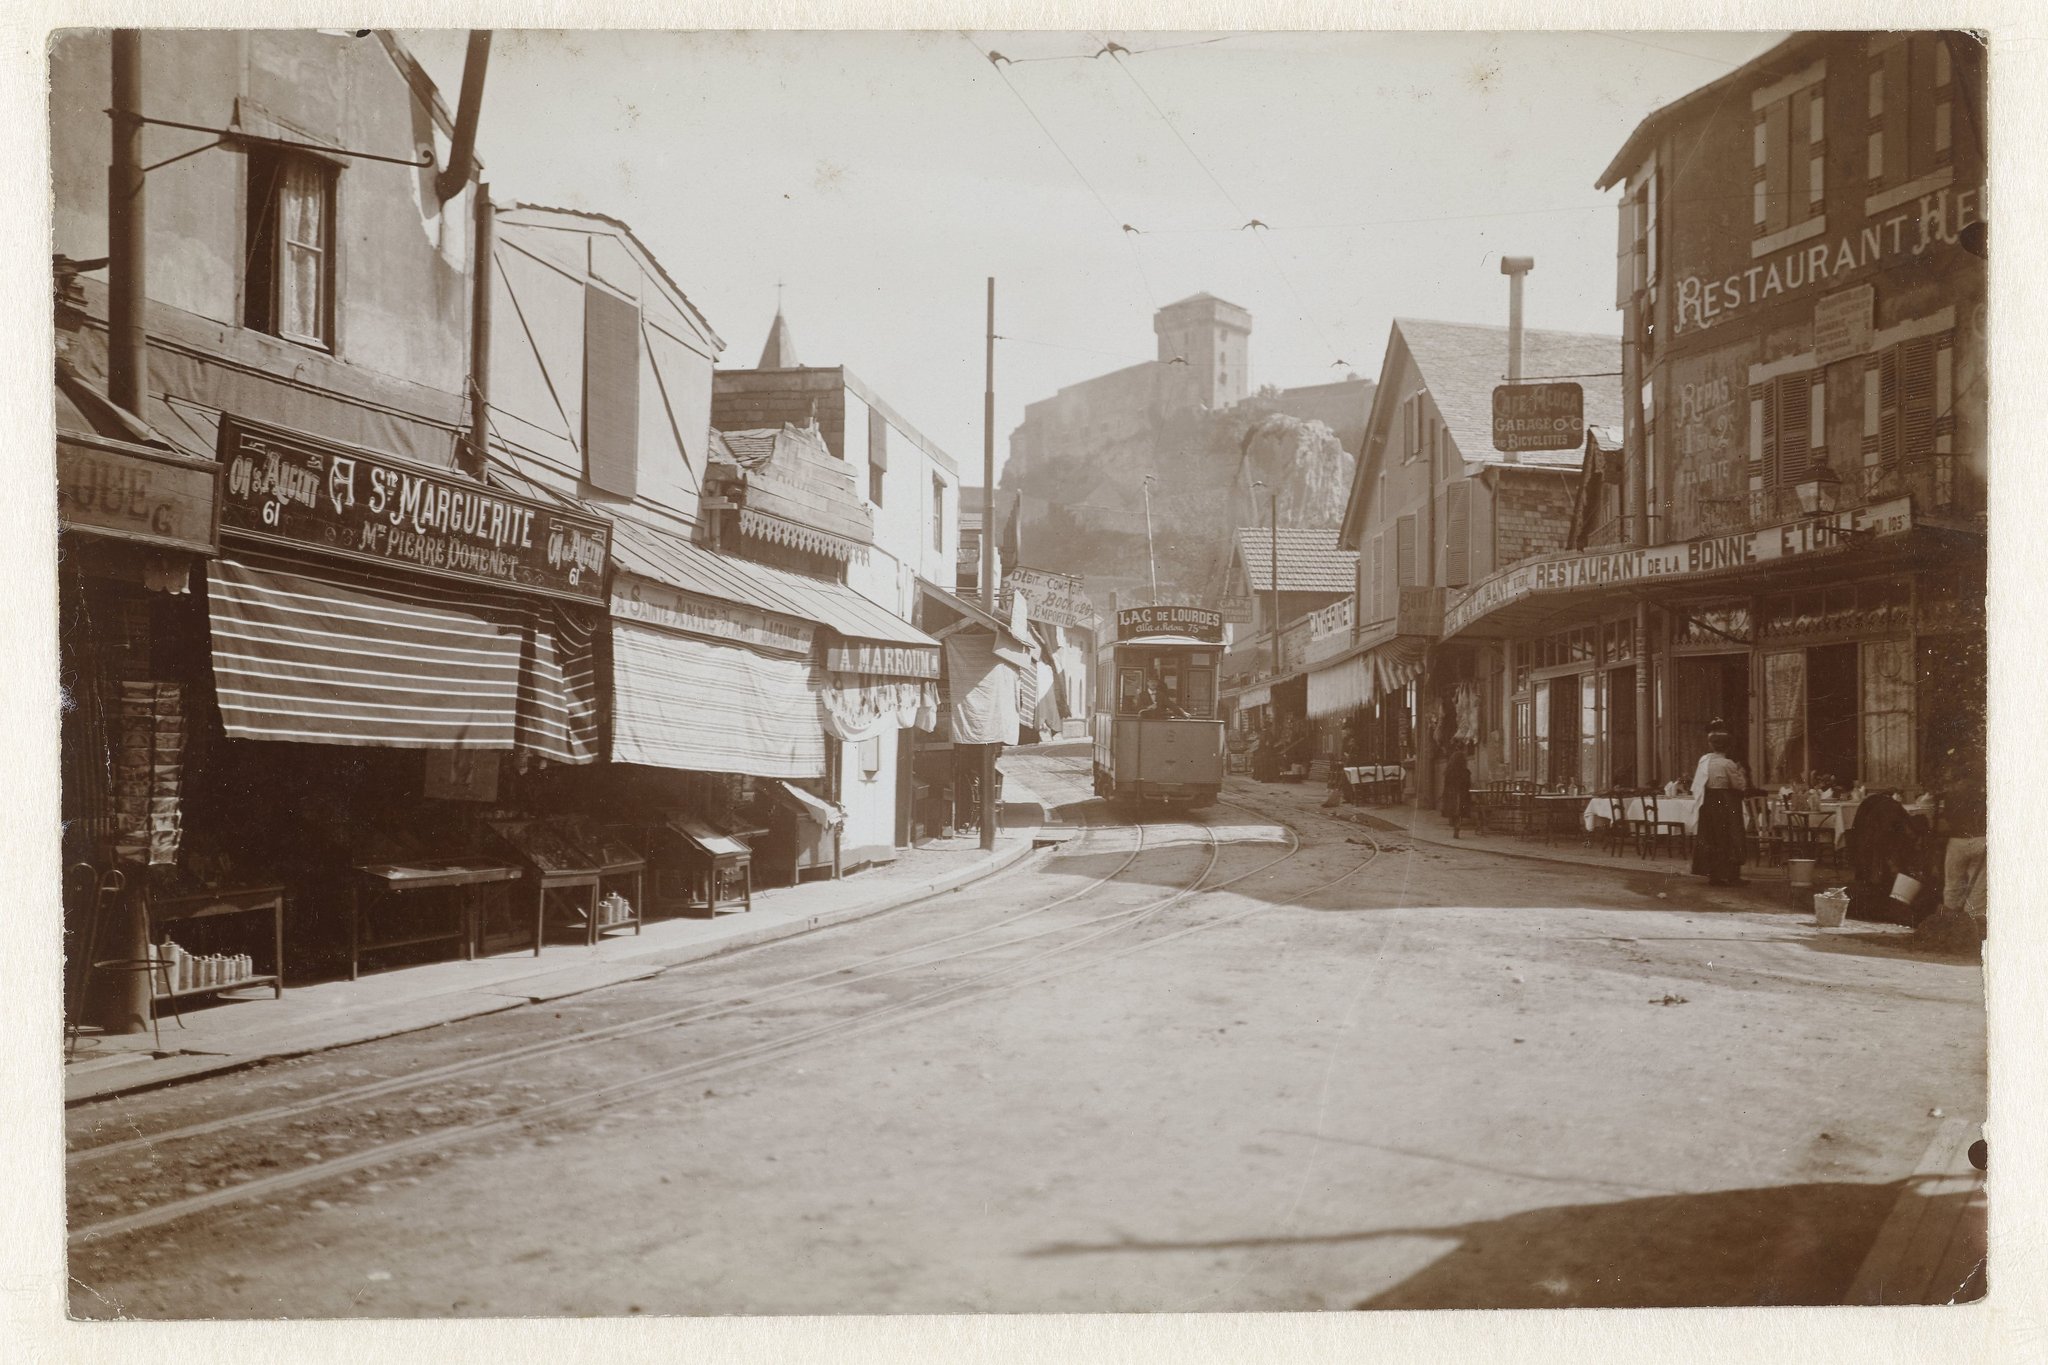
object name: photograph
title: Lourdes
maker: Anonymous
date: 1880-1910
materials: paper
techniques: collodion silver print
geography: lourdes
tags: tram